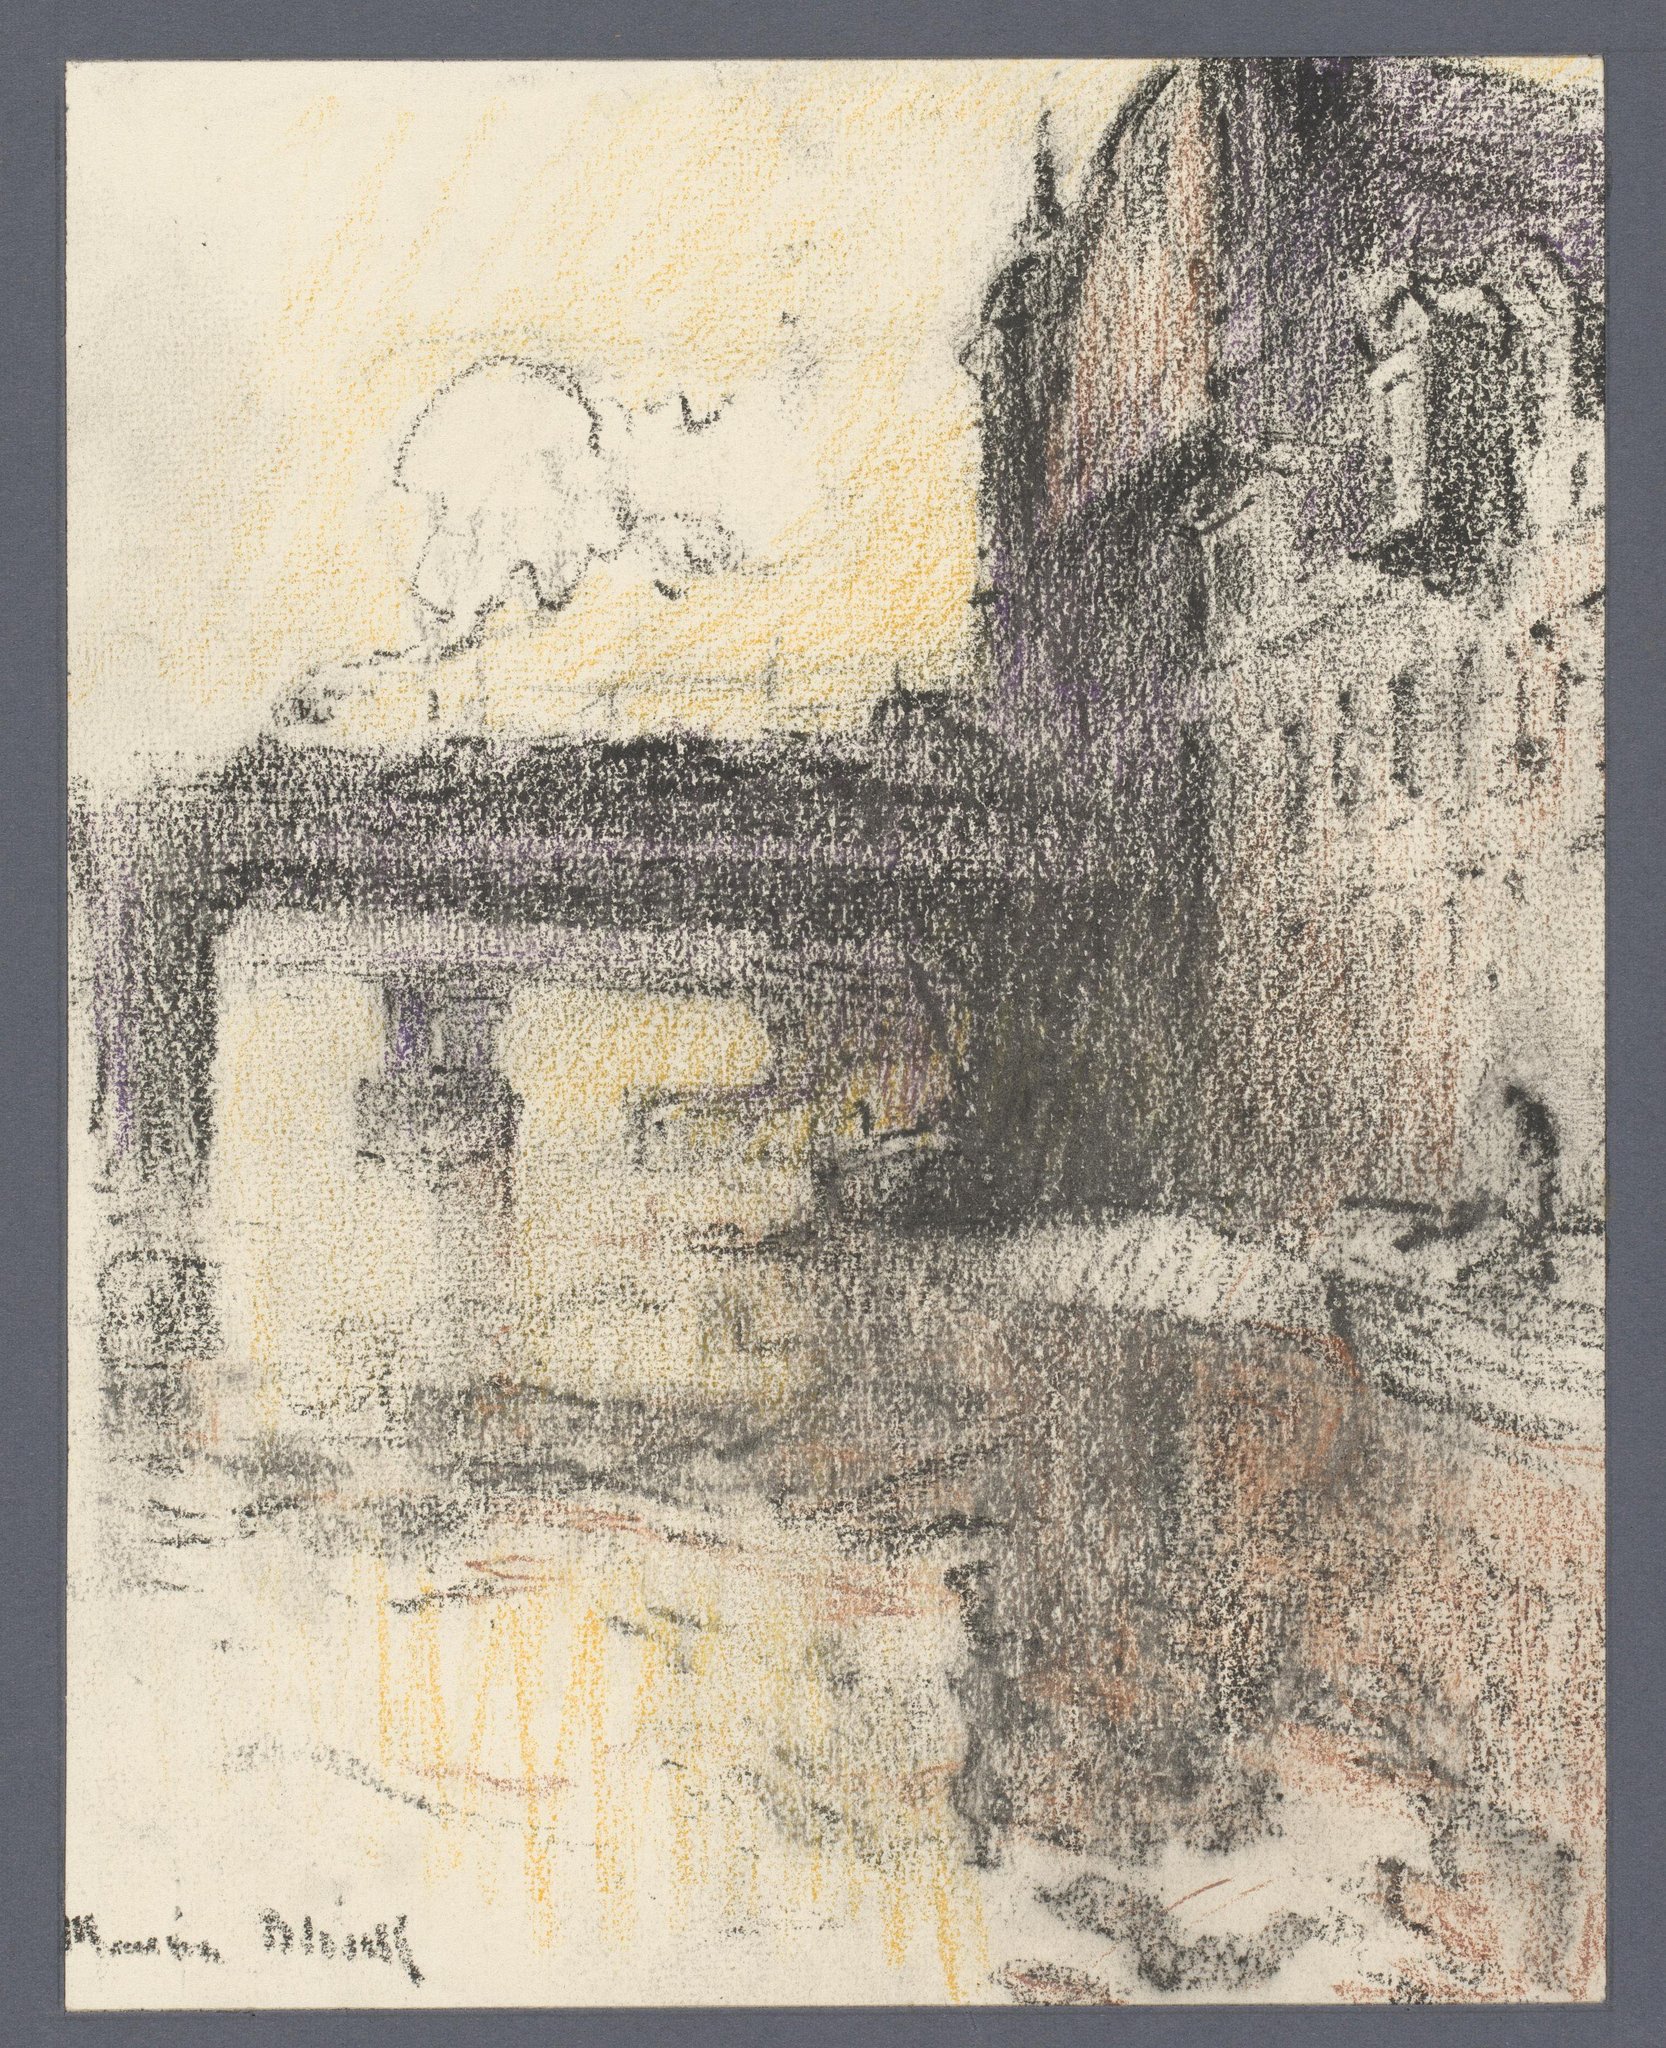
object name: drawing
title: Trein op een viaduct in Londen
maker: maurice blieck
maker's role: draughtsman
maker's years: 1876-1922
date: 1886-1918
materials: chalk, paper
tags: viaduct, railway-traffic, canals, waters (in city), london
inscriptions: collector's mark: Lugt 2228